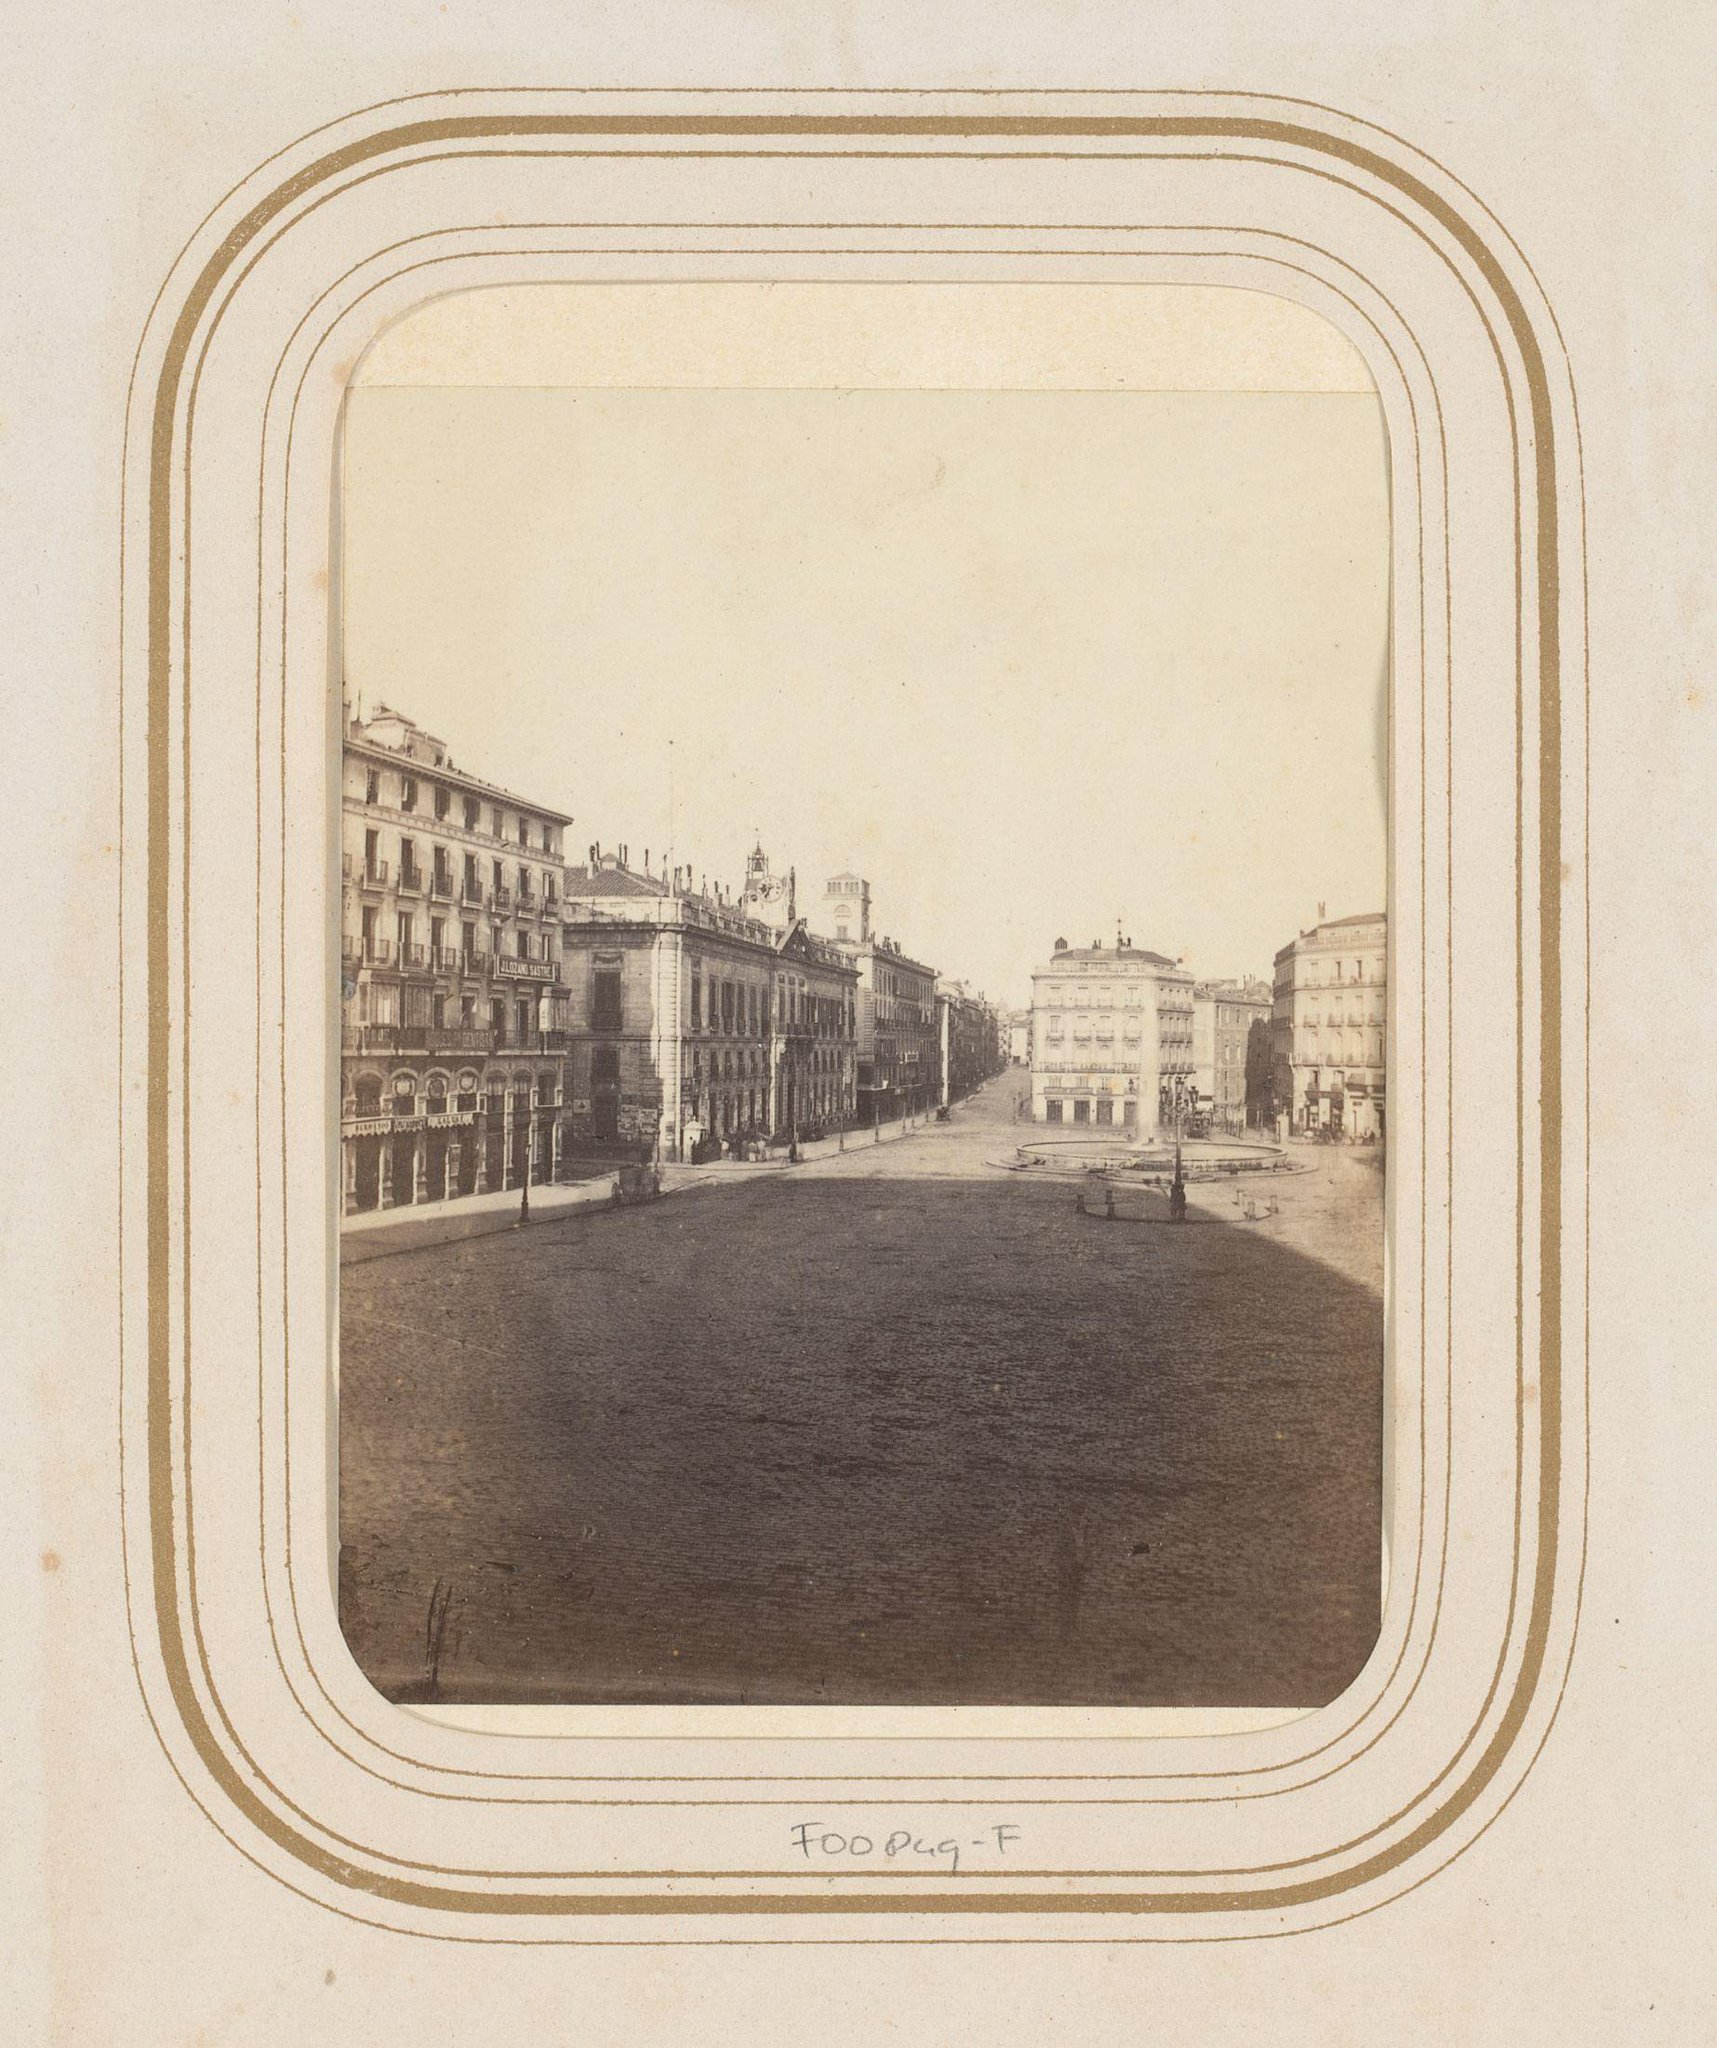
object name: cabinet photograph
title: Gezicht op een plein met fontein in Spanje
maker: juan laurent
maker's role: publisher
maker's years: 1816-1896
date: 1857-1880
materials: cardboard, photographic support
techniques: albumen print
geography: spain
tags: square, place, circus, etc., ornamental fountain, spain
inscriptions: inscription: ‘MONUMENTS ET VUES D'ESPAGNE/ J. LAURENT, Fotog. / Dépot Central./ 39, Carrera S. Geronimo, MADRID/ 27, Rue Richelieu, PARIS’